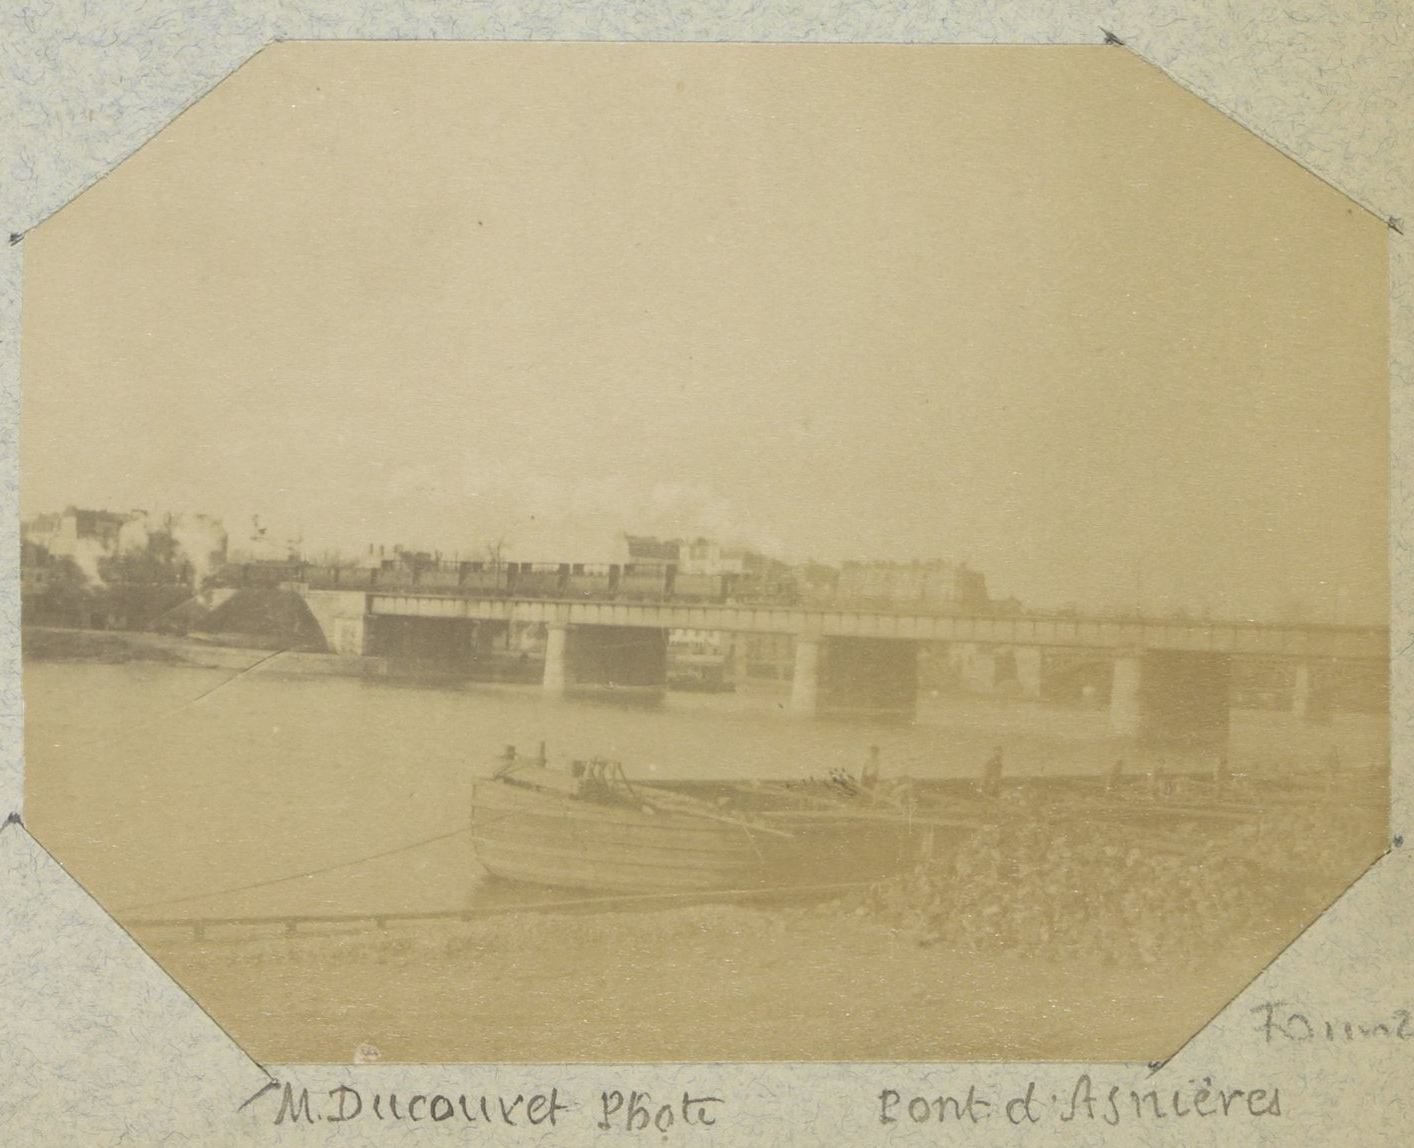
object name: album leaf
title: Gezicht op een brug over de Seine bij Asnières met op de voorgrond een schip aan een kade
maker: m. ducouvet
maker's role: fotograaf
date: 1880-1900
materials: paper, photographic support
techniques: albumen print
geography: asnières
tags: sailing-ship, sailing-boat, quay (+ city(-scape) with figures, staffage), bridge in city across river, canal, etc.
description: Onderdeel van Album van een Franse amateur met foto's van Frankrijk, Algerije, Palmyra, de Wereldtentoonstelling van 1900 en van bekende Fransen.